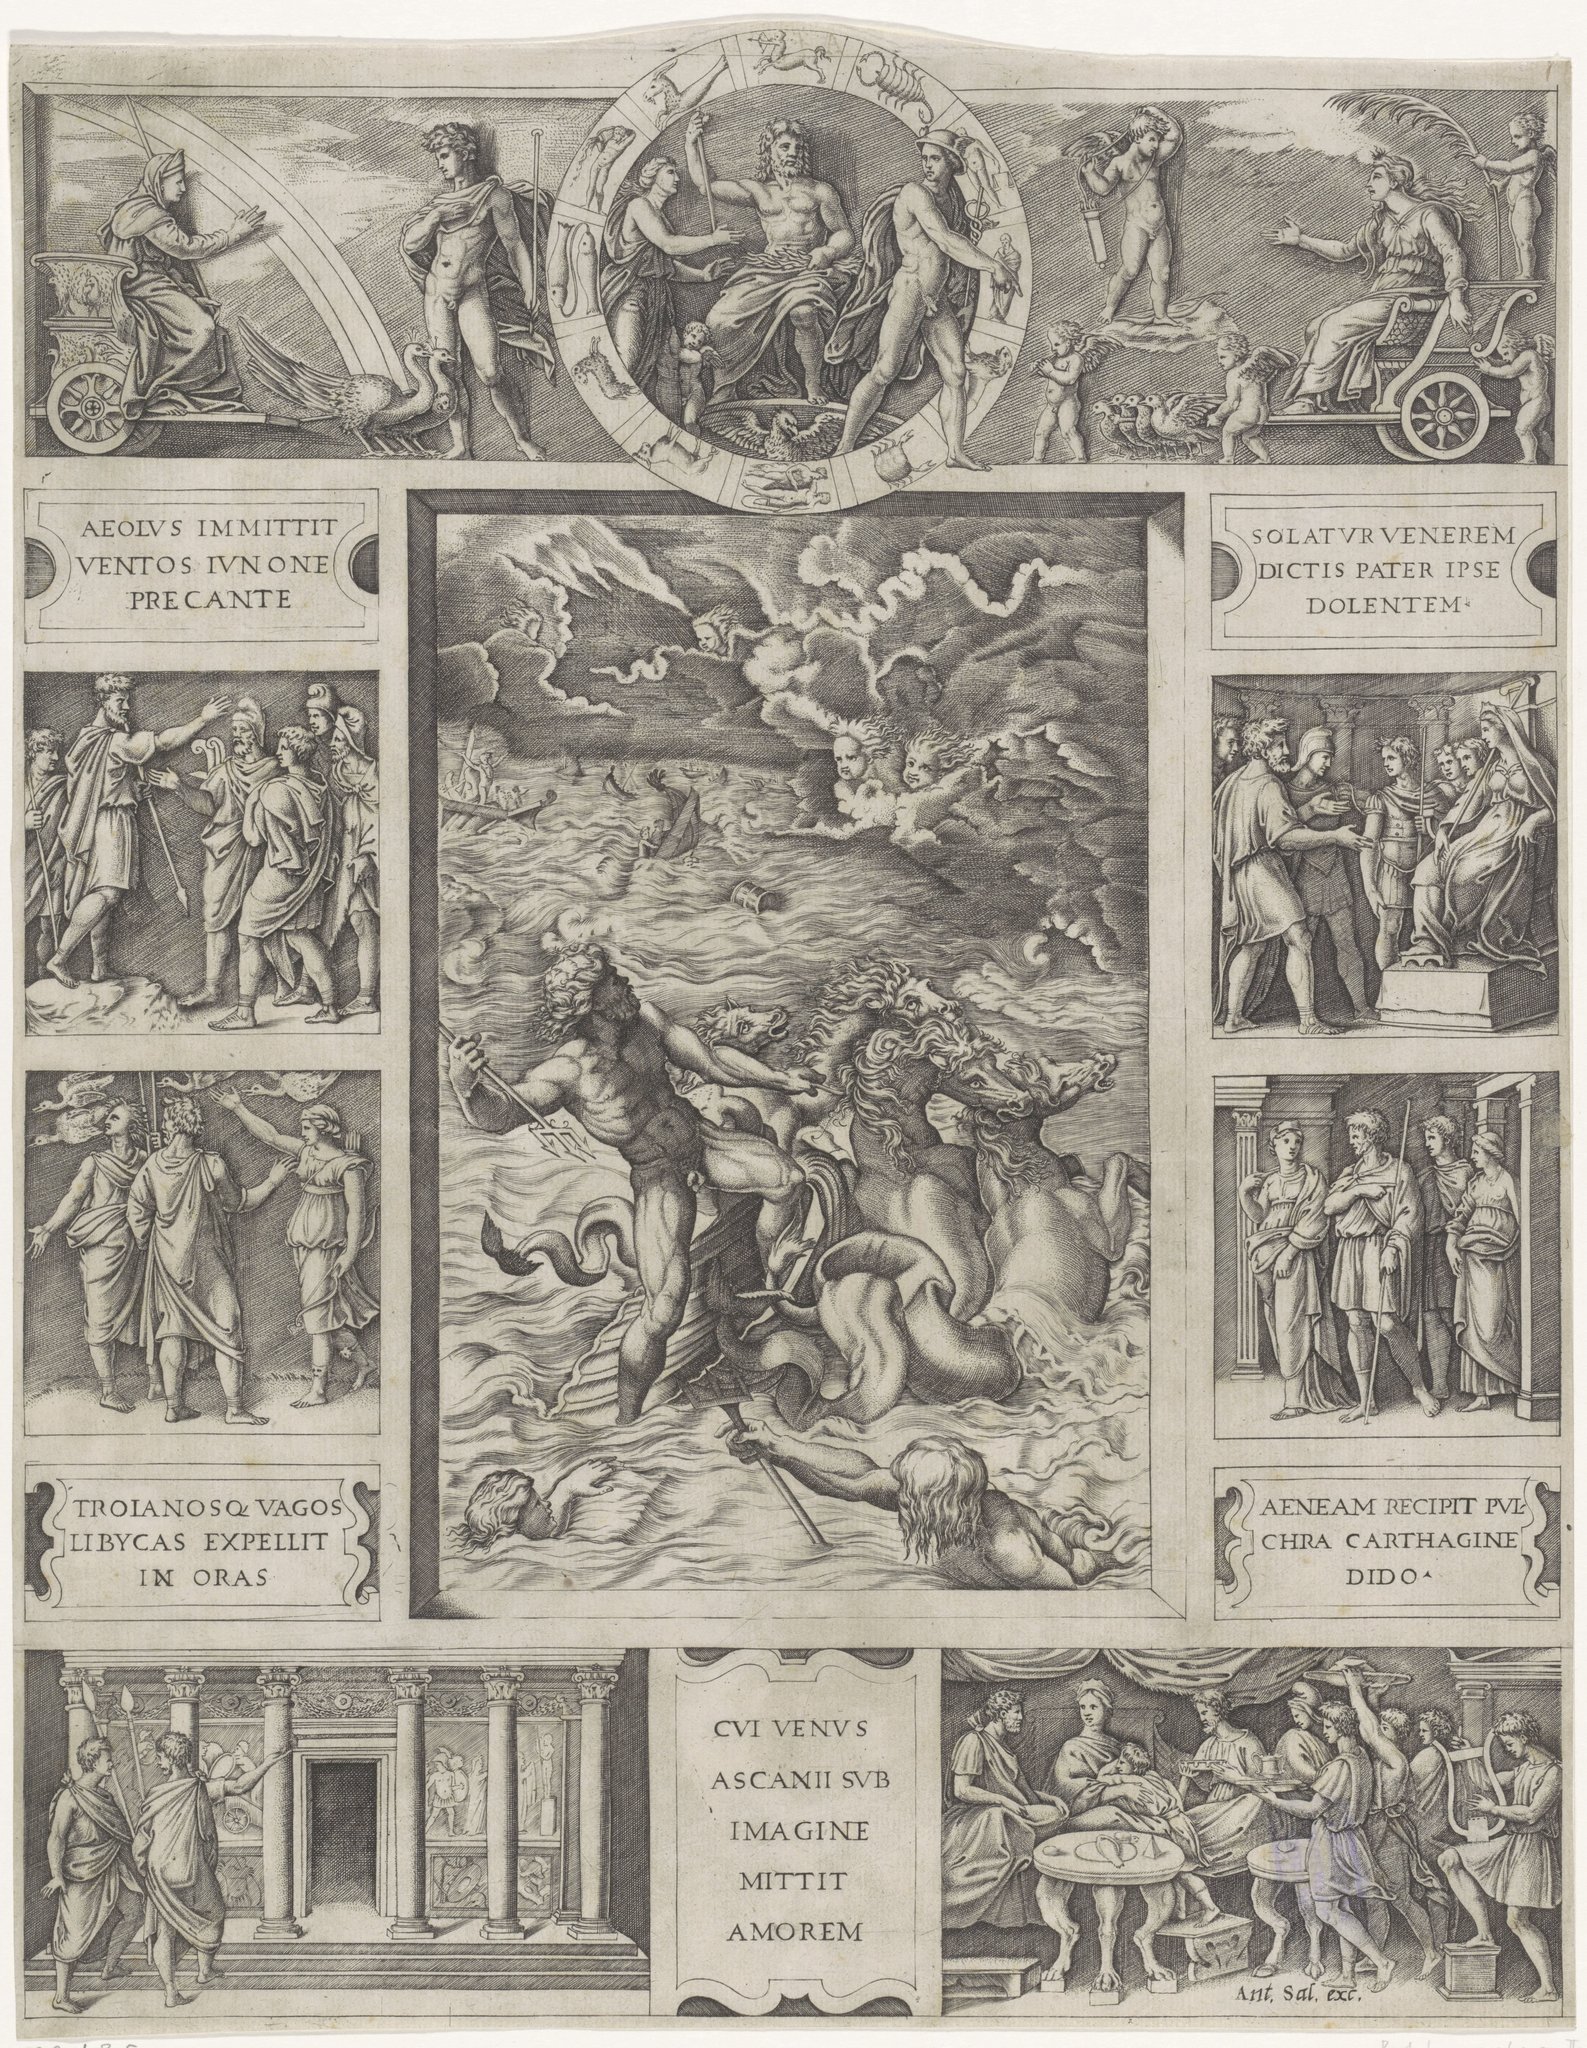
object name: print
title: Jupiter bedaart de storm op zee in rechthoekige omlijsting met negen scènes uit epos Aeneis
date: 1515-1516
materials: paper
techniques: engraving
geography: rome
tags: (story of) neptune (poseidon), the story of aeneas' wanderings to italy (virgil, aeneid), neptune quieting the storm, 'quos ego' (virgil, aeneid i 135)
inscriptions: collector's mark: Lugt 10, collector's mark: Lugt 11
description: Jupiter bedaart de storm op zee in rechthoekige omlijsting met negen scènes uit het epos Aeneis van Vergilius in willekeurige volgorde weergegeven. De voorstellingen worden geduid met teksten in het Latijn.